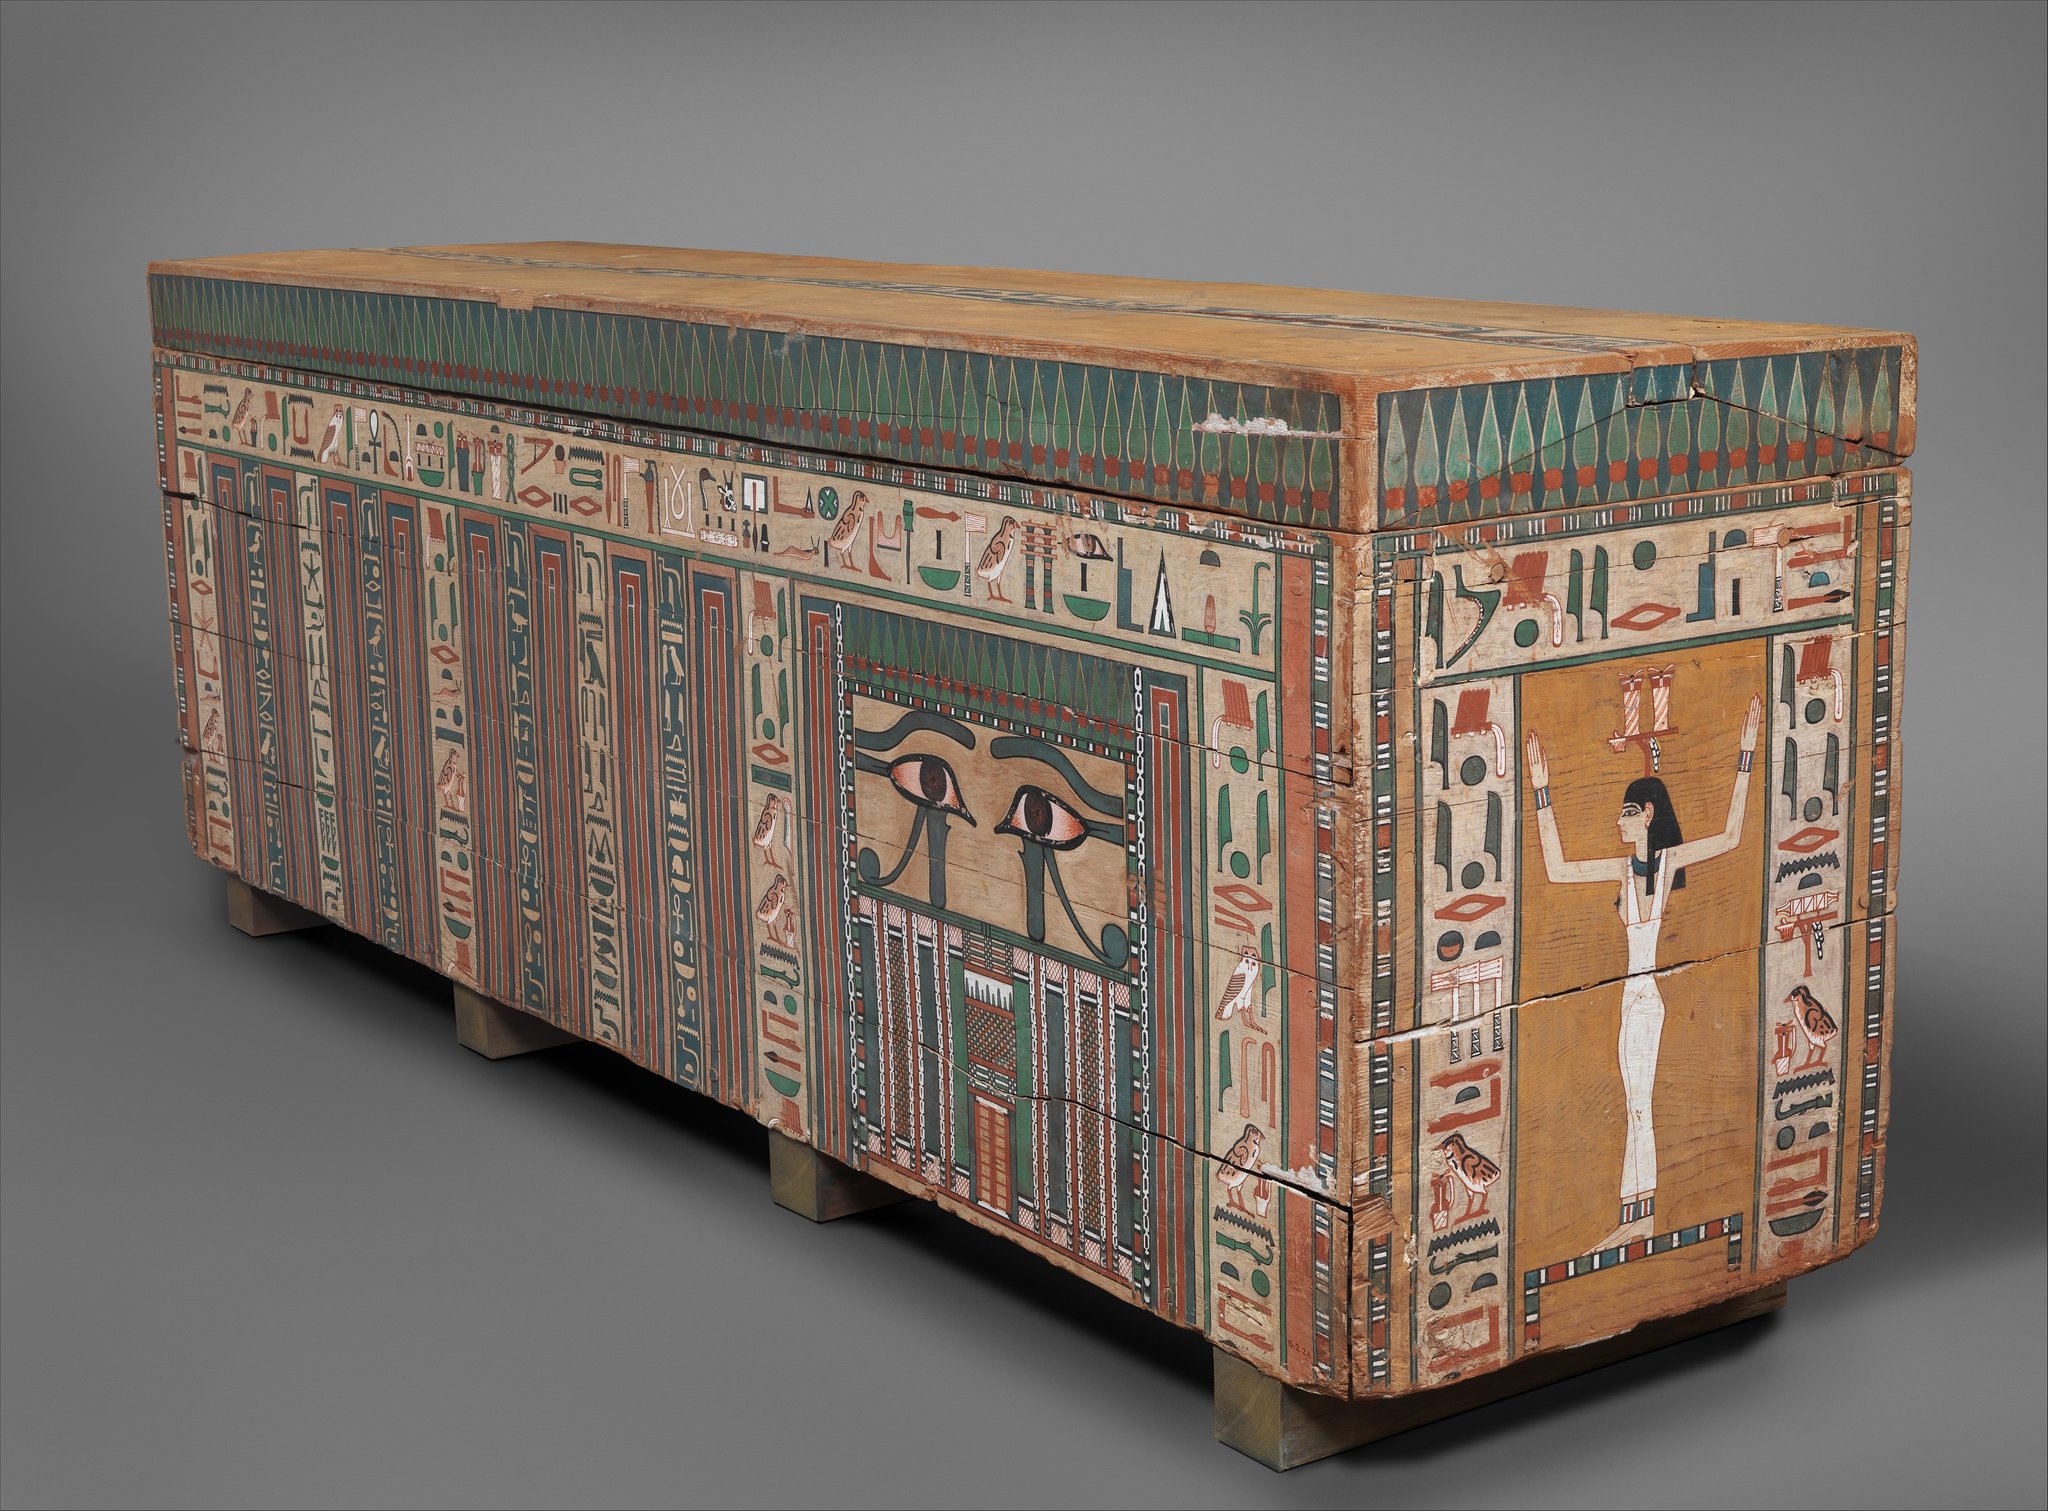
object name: coffin, khnumnakht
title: Coffin of Khnumnakht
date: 1850-1750 BCE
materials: paint, wood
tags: eyes,hieroglyphs,goddess,coffins